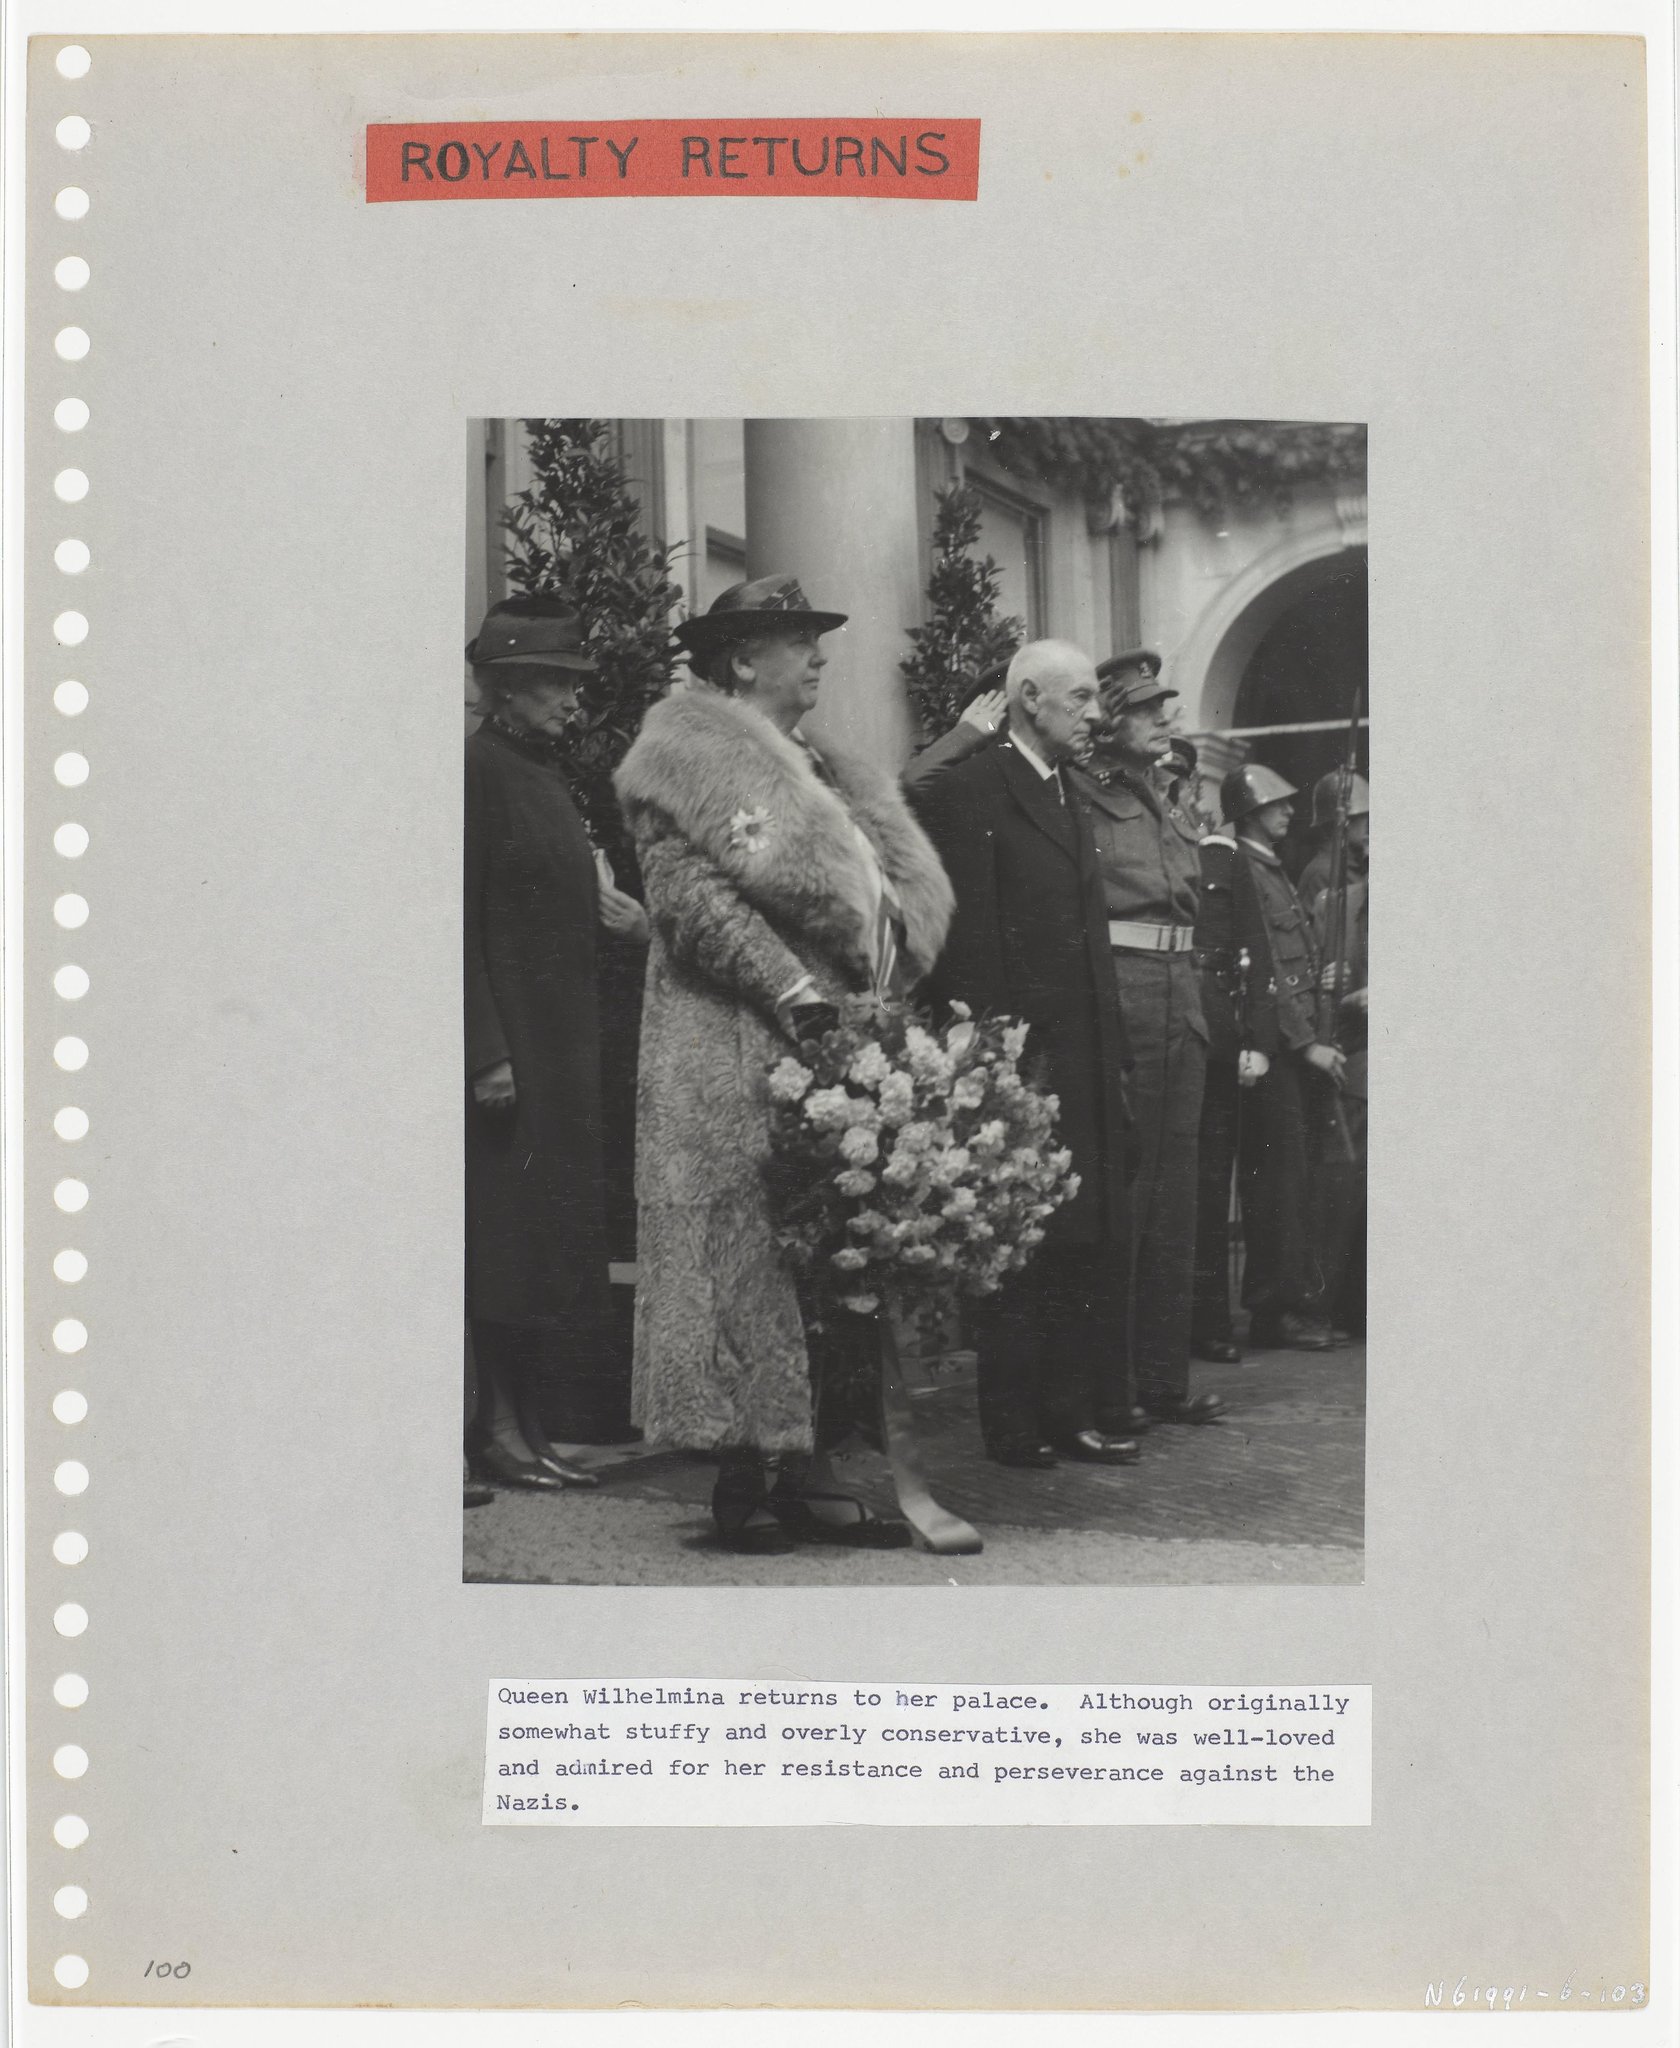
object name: photograph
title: Koningin Wilhelmina op paleis Noordeinde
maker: Anonymous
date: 1945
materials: paper, plastic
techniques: photography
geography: the hague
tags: the hague, print maker, wilhelmina of the netherlands, amsterdam, tonny van renterghem, berlin, fritz kahlenberg, underground movement, partisans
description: Koningin Wilhelmina op paleis Noordeinde tijdens haar officiële rentrée in Den Haag.